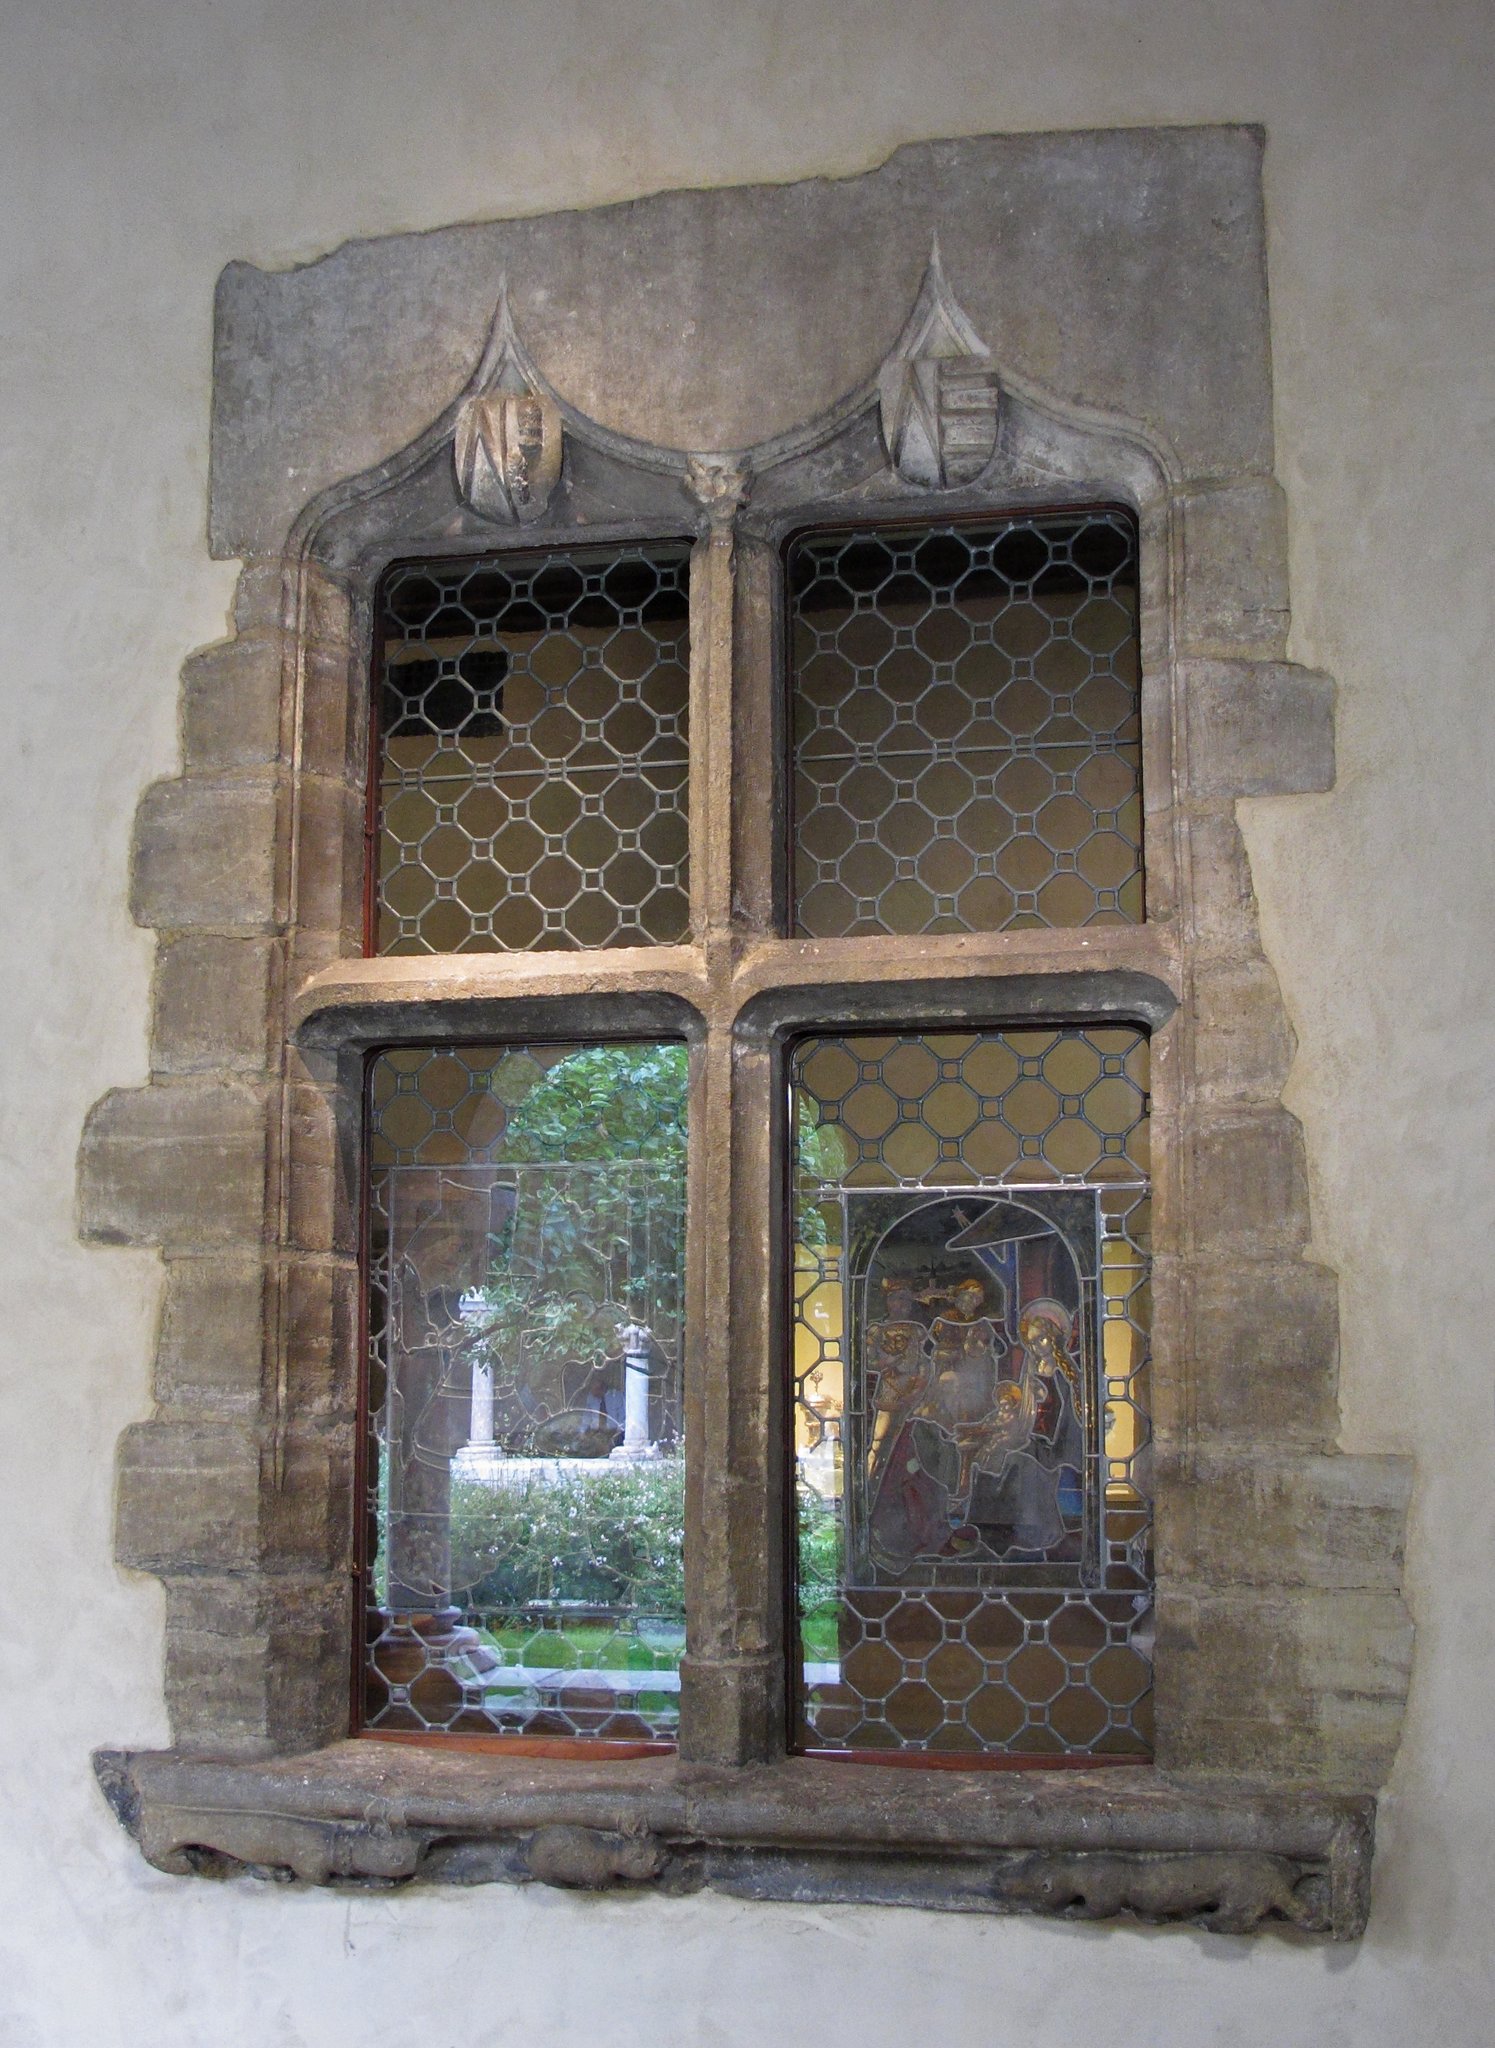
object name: window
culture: french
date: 1467-1500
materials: limestone